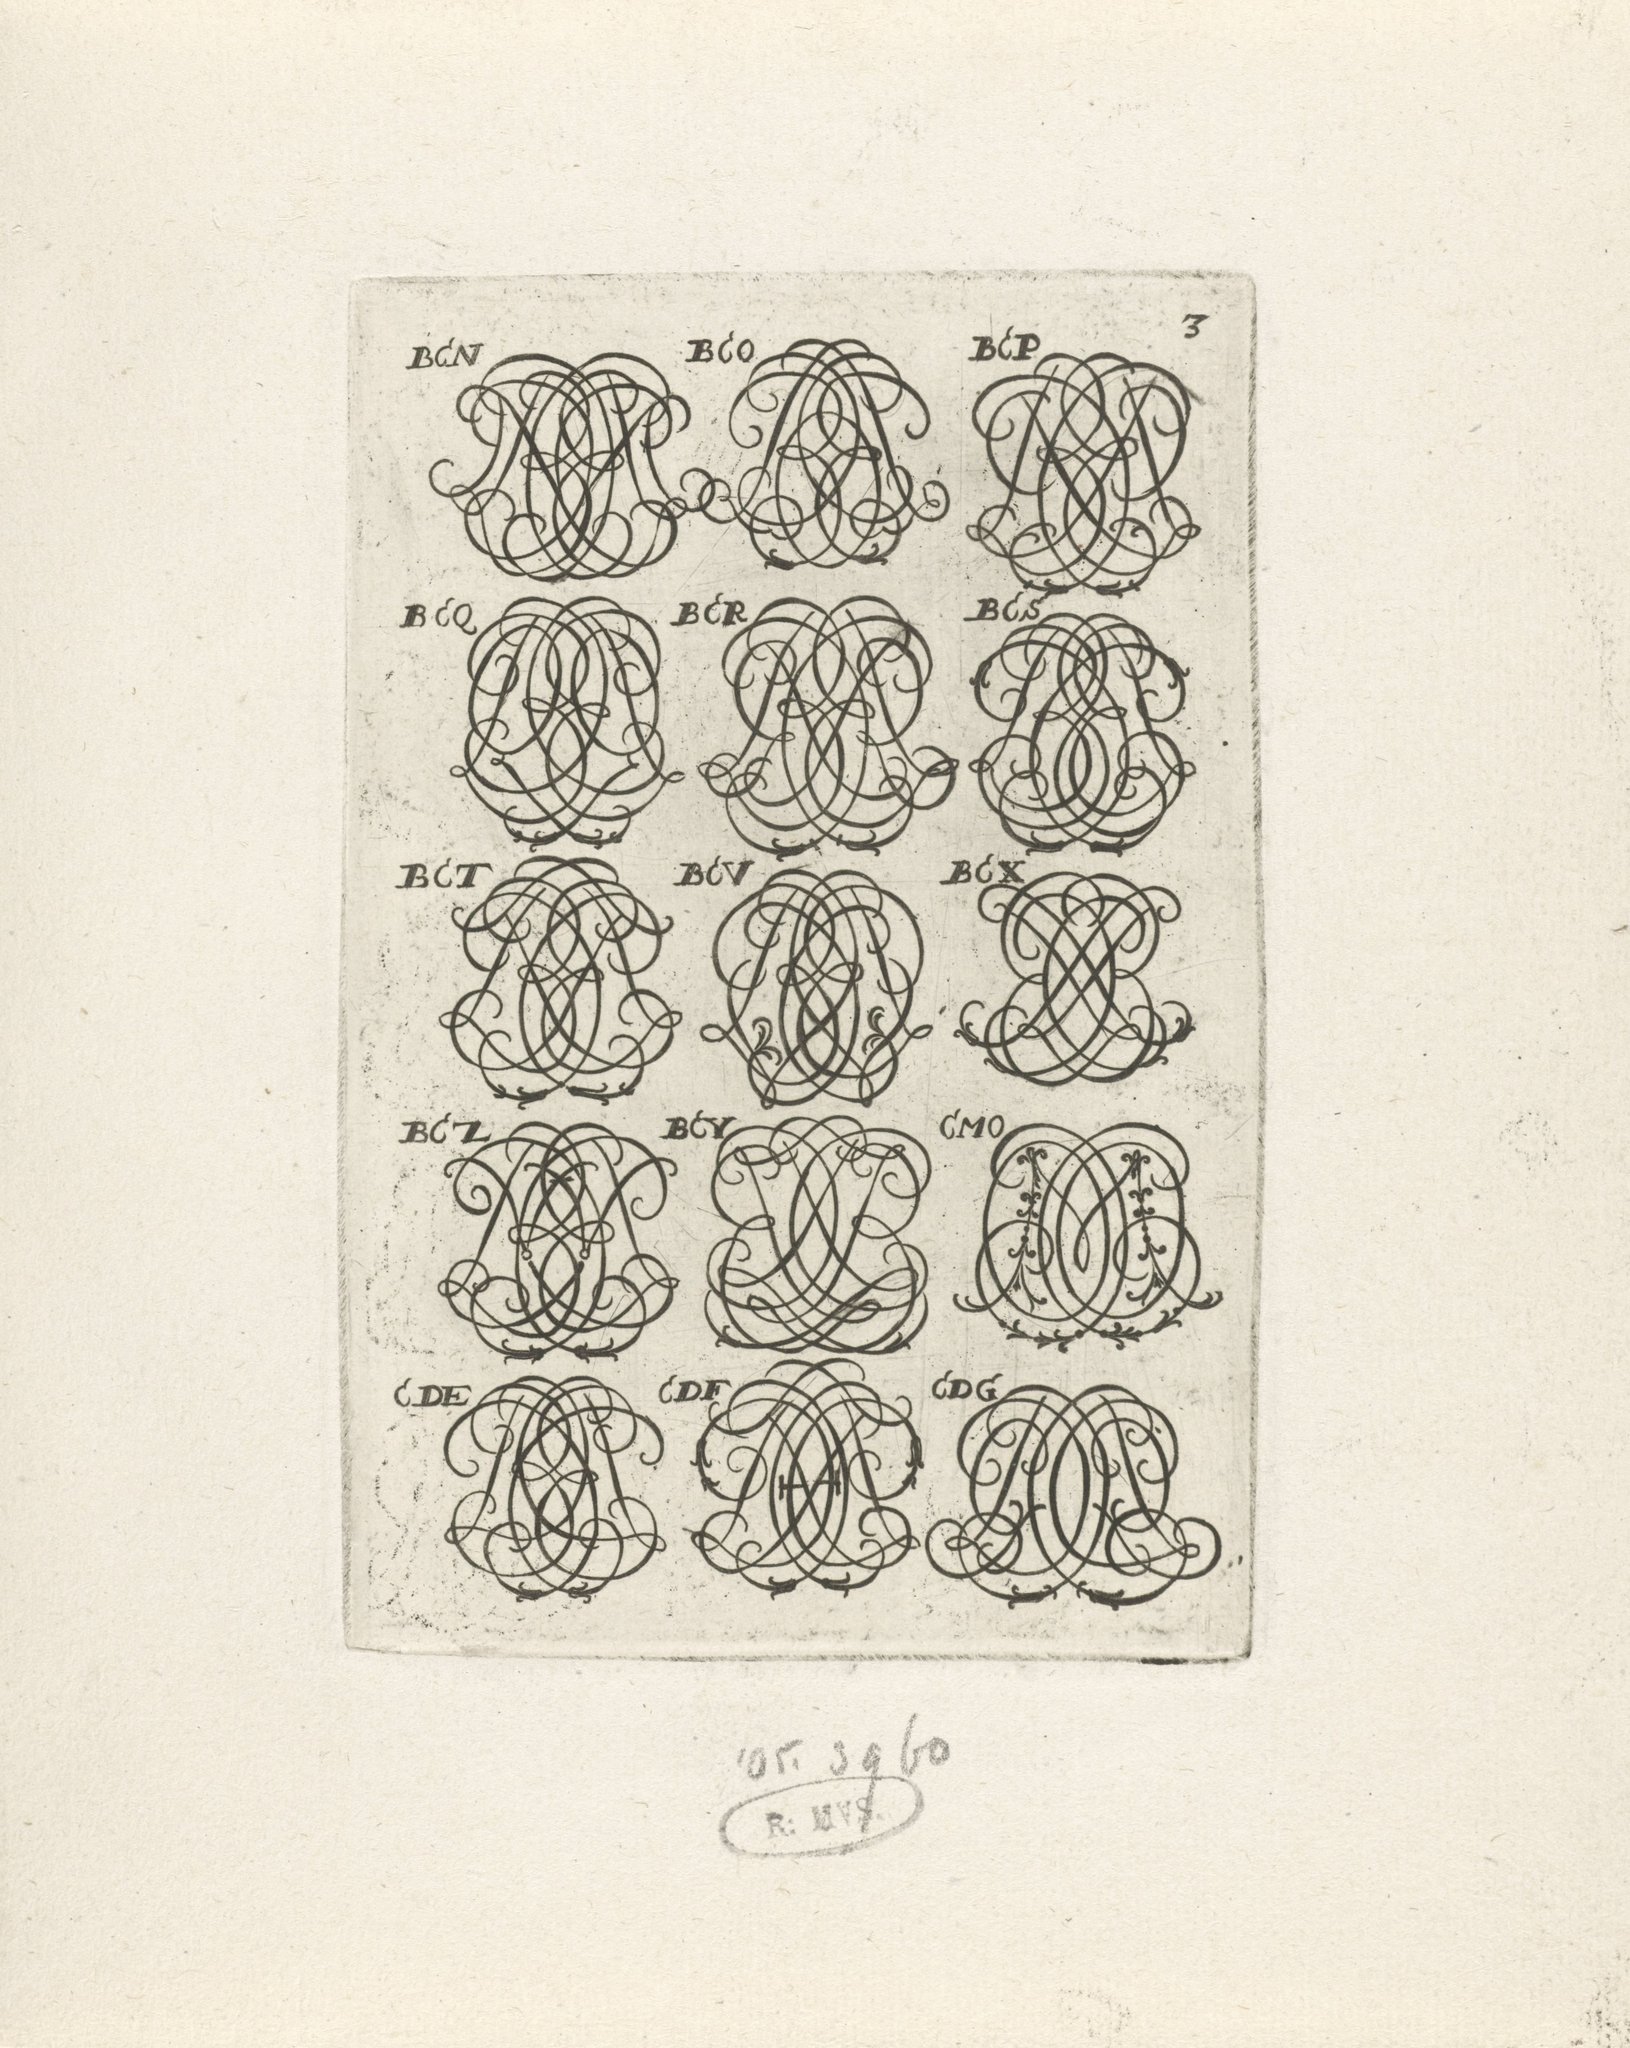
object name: ornament print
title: Livre nouveau et utile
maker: daniel de lafeuille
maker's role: print maker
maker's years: 1640-1709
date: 1690-1691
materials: paper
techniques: engraving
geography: amsterdam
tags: letters, alphabet, script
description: Uit serie van 29 deels genummerde bladen met cijfermonogrammen.